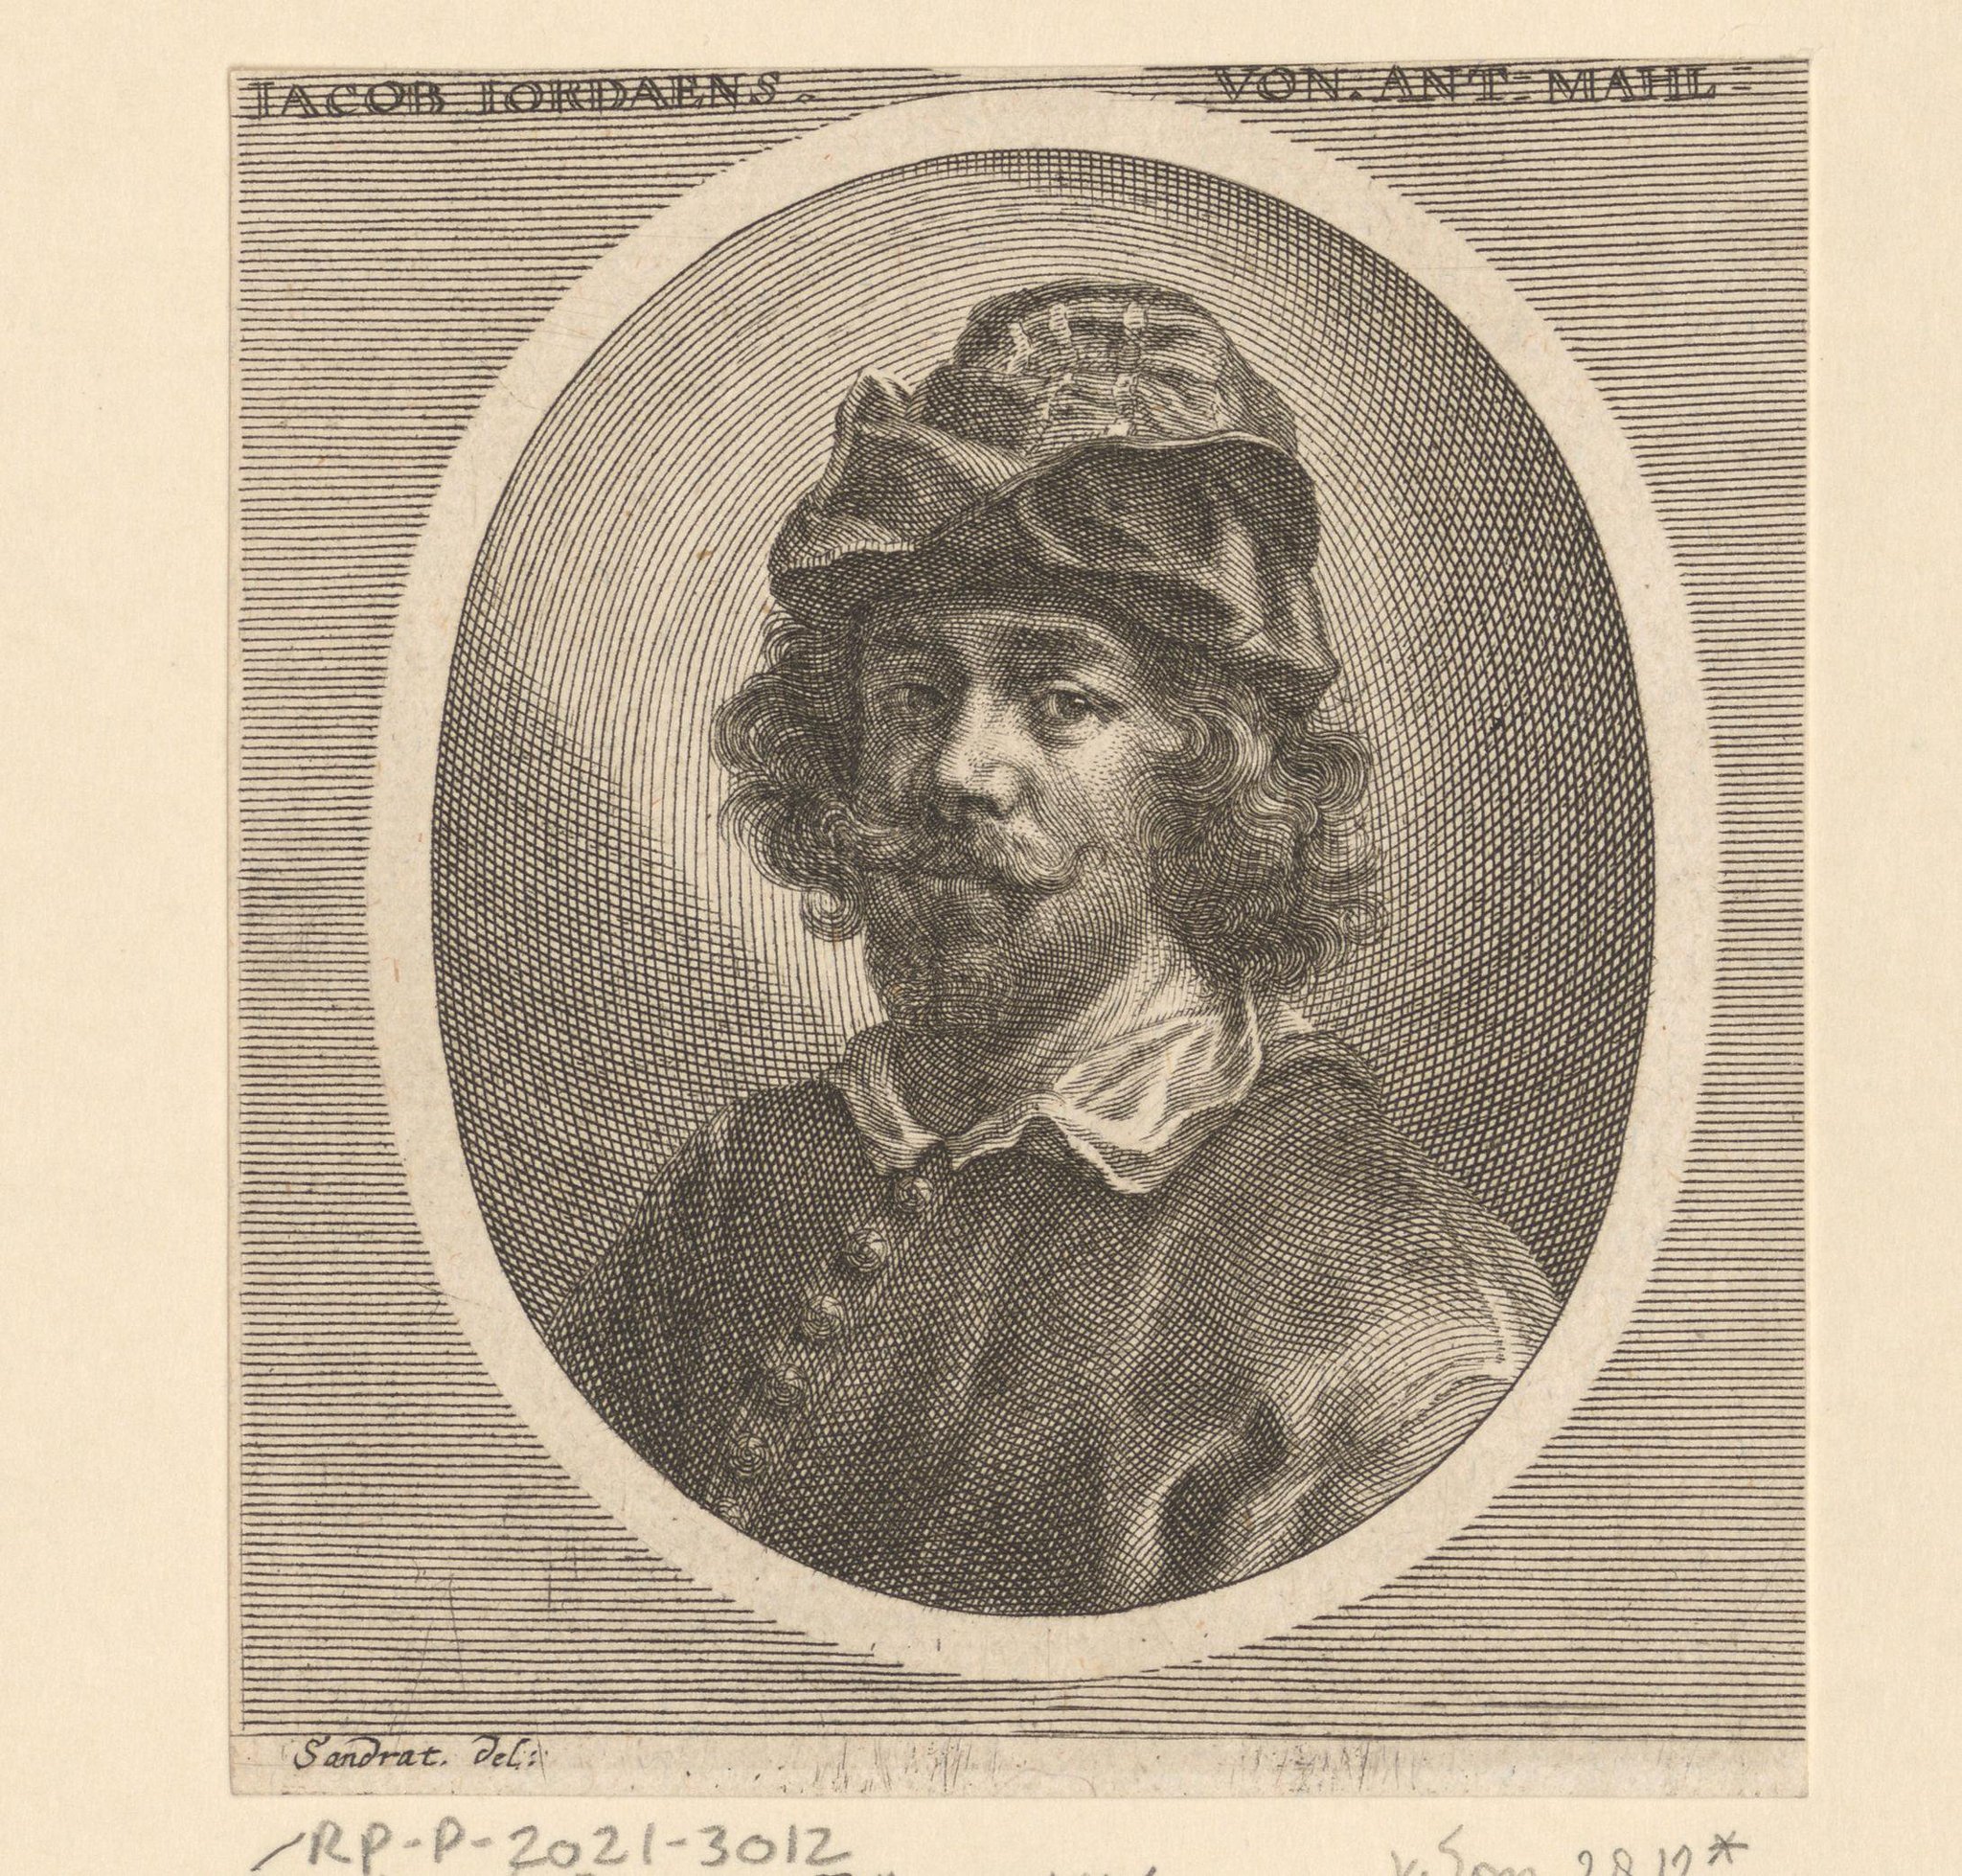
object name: print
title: Portret van Jacques Jordaens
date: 1637-1697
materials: paper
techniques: engraving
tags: painter, print maker, draughtsman, designer, jacques jordaens, historical persons, portrait, self-portrait of painter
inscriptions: collector's mark: Lugt 2228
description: Deze prent maakt deel uit van een grotere prent met zes portretten die later is verknipt.